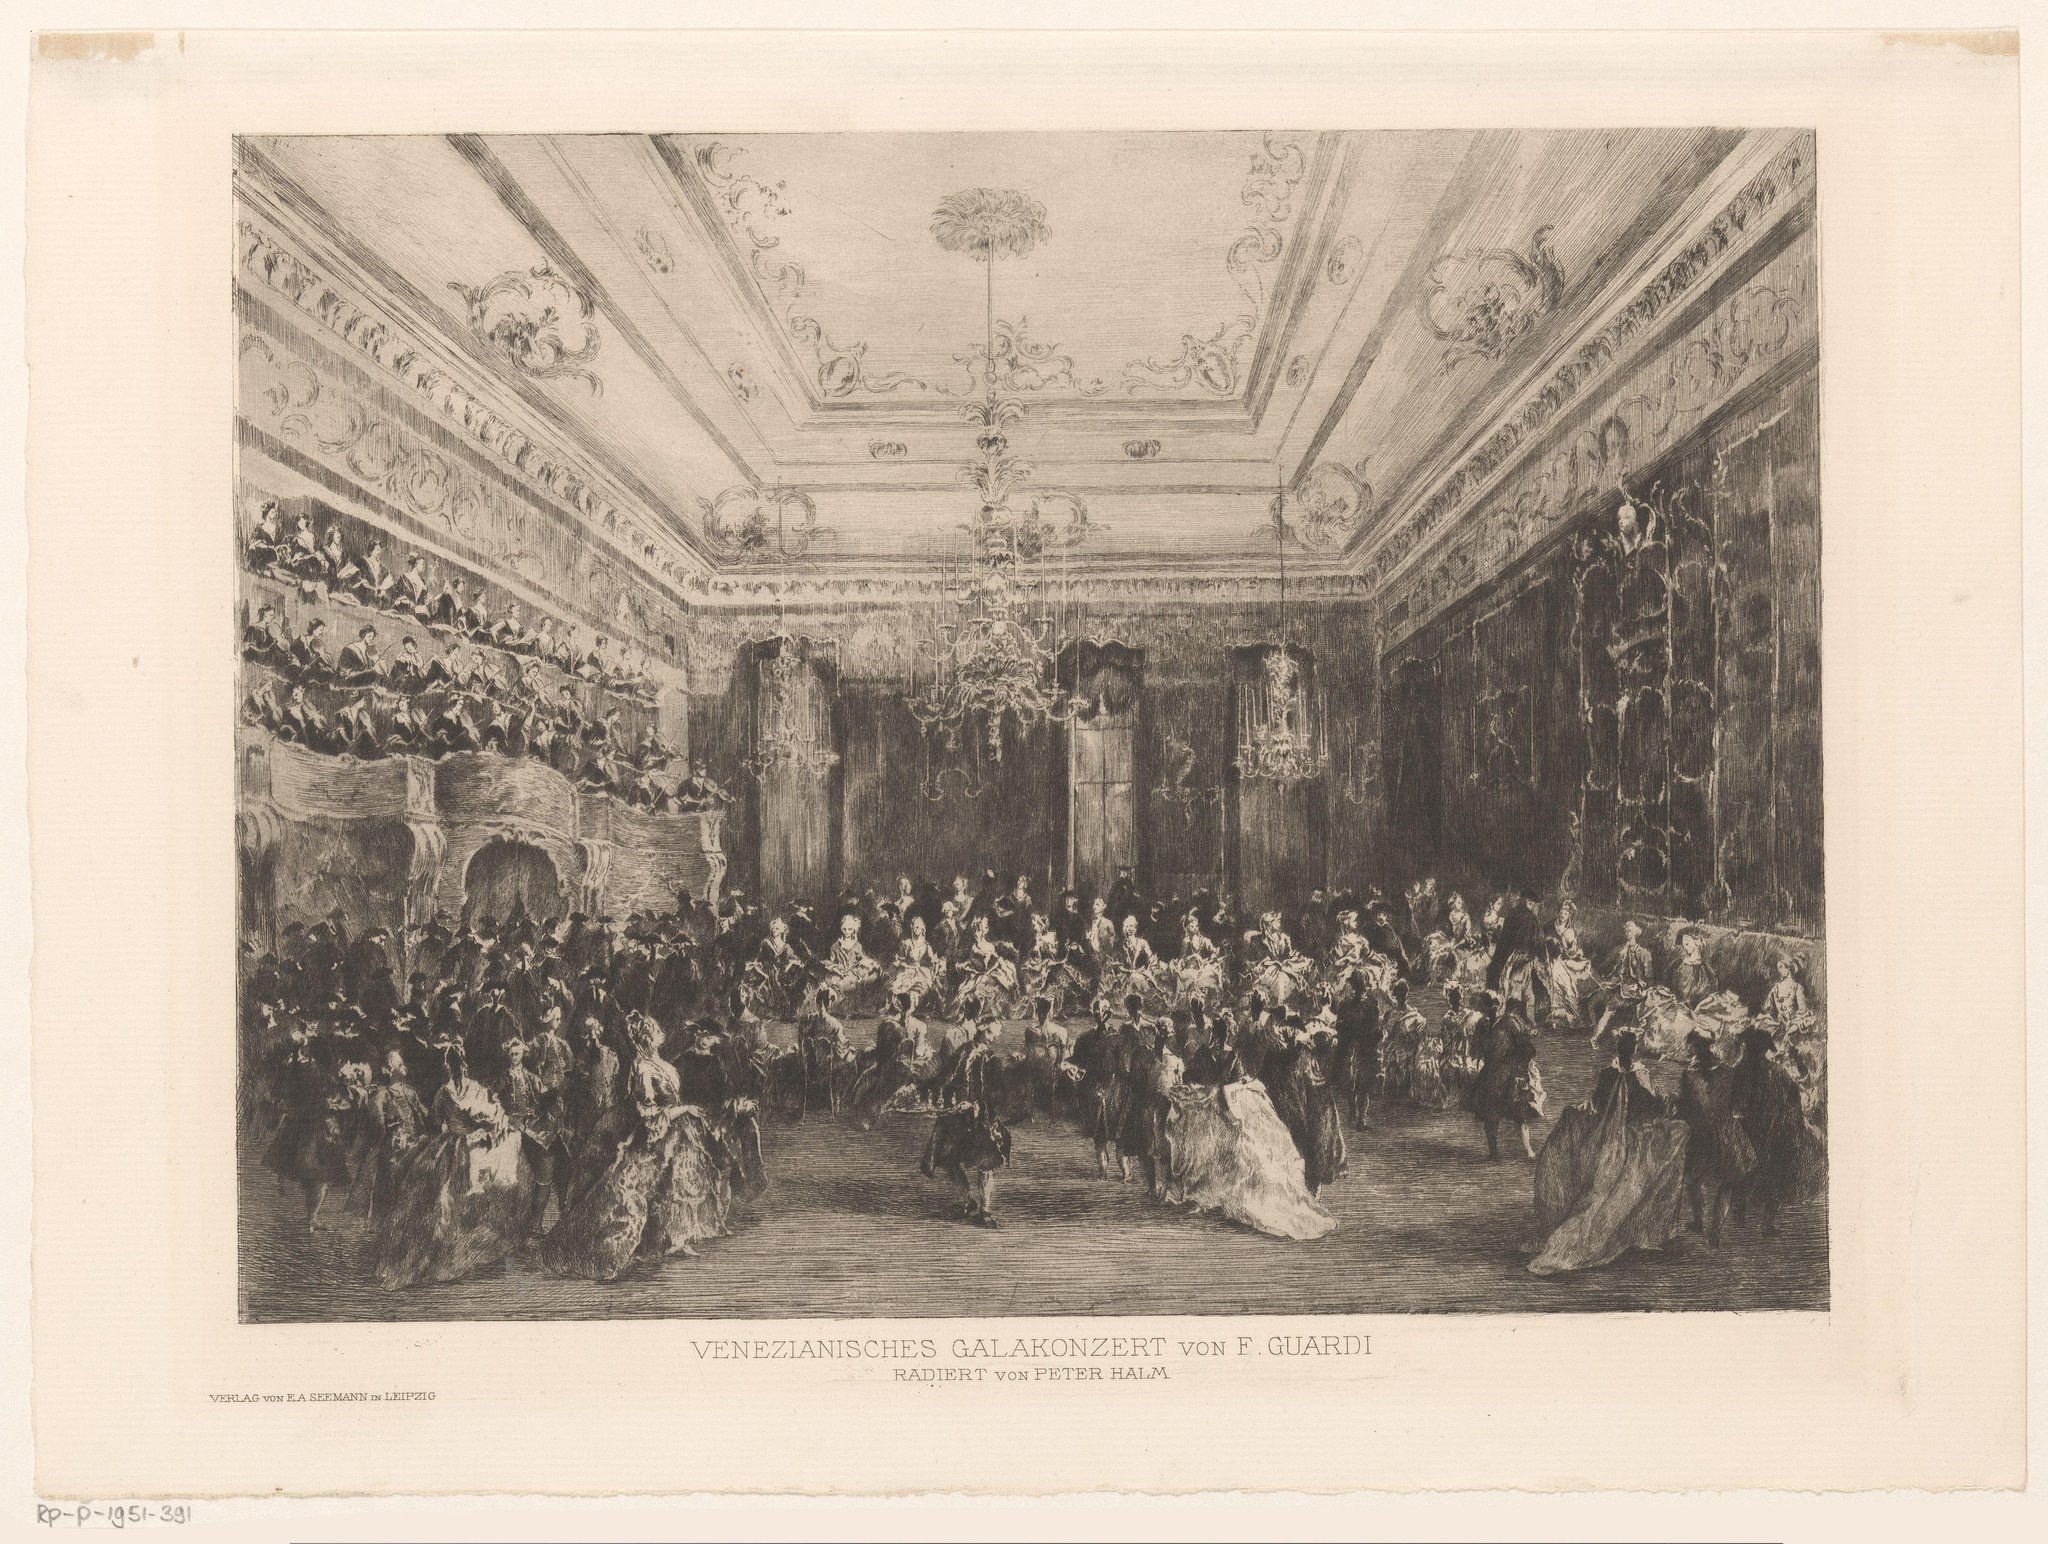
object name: print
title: Venezianisches Galakonzert von F. Guardi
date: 1864-1923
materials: paper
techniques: drypoint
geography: leipzig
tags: concert hall, venice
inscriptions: collector's mark: Lugt 2228